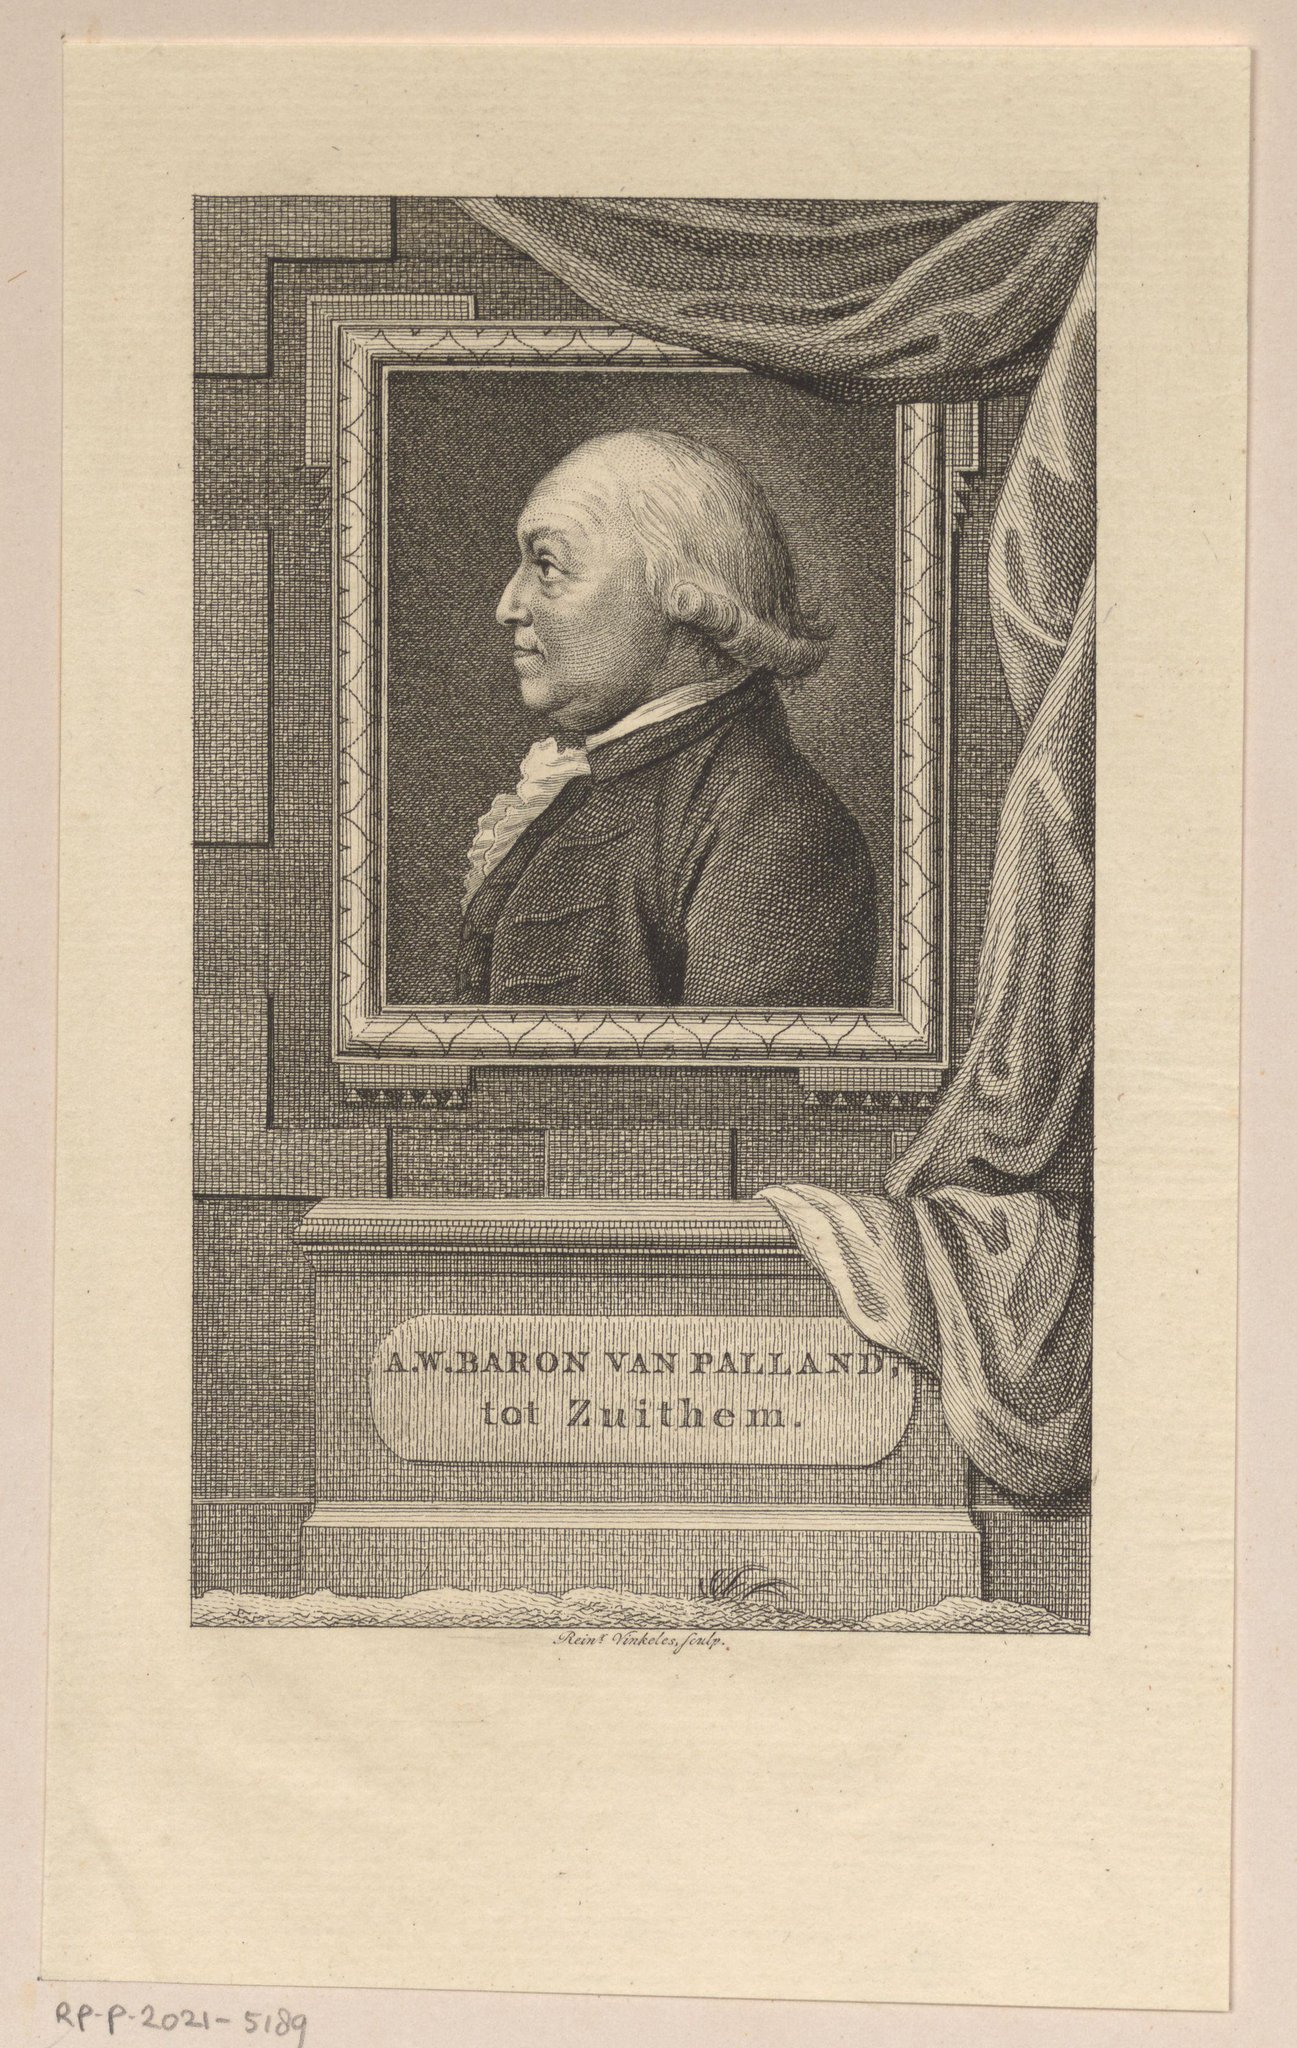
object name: print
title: Portret van Adolph Werner van Pallandt tot Zuthem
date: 1786-1809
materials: paper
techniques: engraving, etching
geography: amsterdam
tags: adult man, historical persons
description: Prent gebruikt in: Wagenaar, Jan. Vaderlandsche historie, (...) ten vervolge van Wagenaars Vaderlandsche historie. 43 dln. Amsterdam: Johannes Allart, 1786-1809.